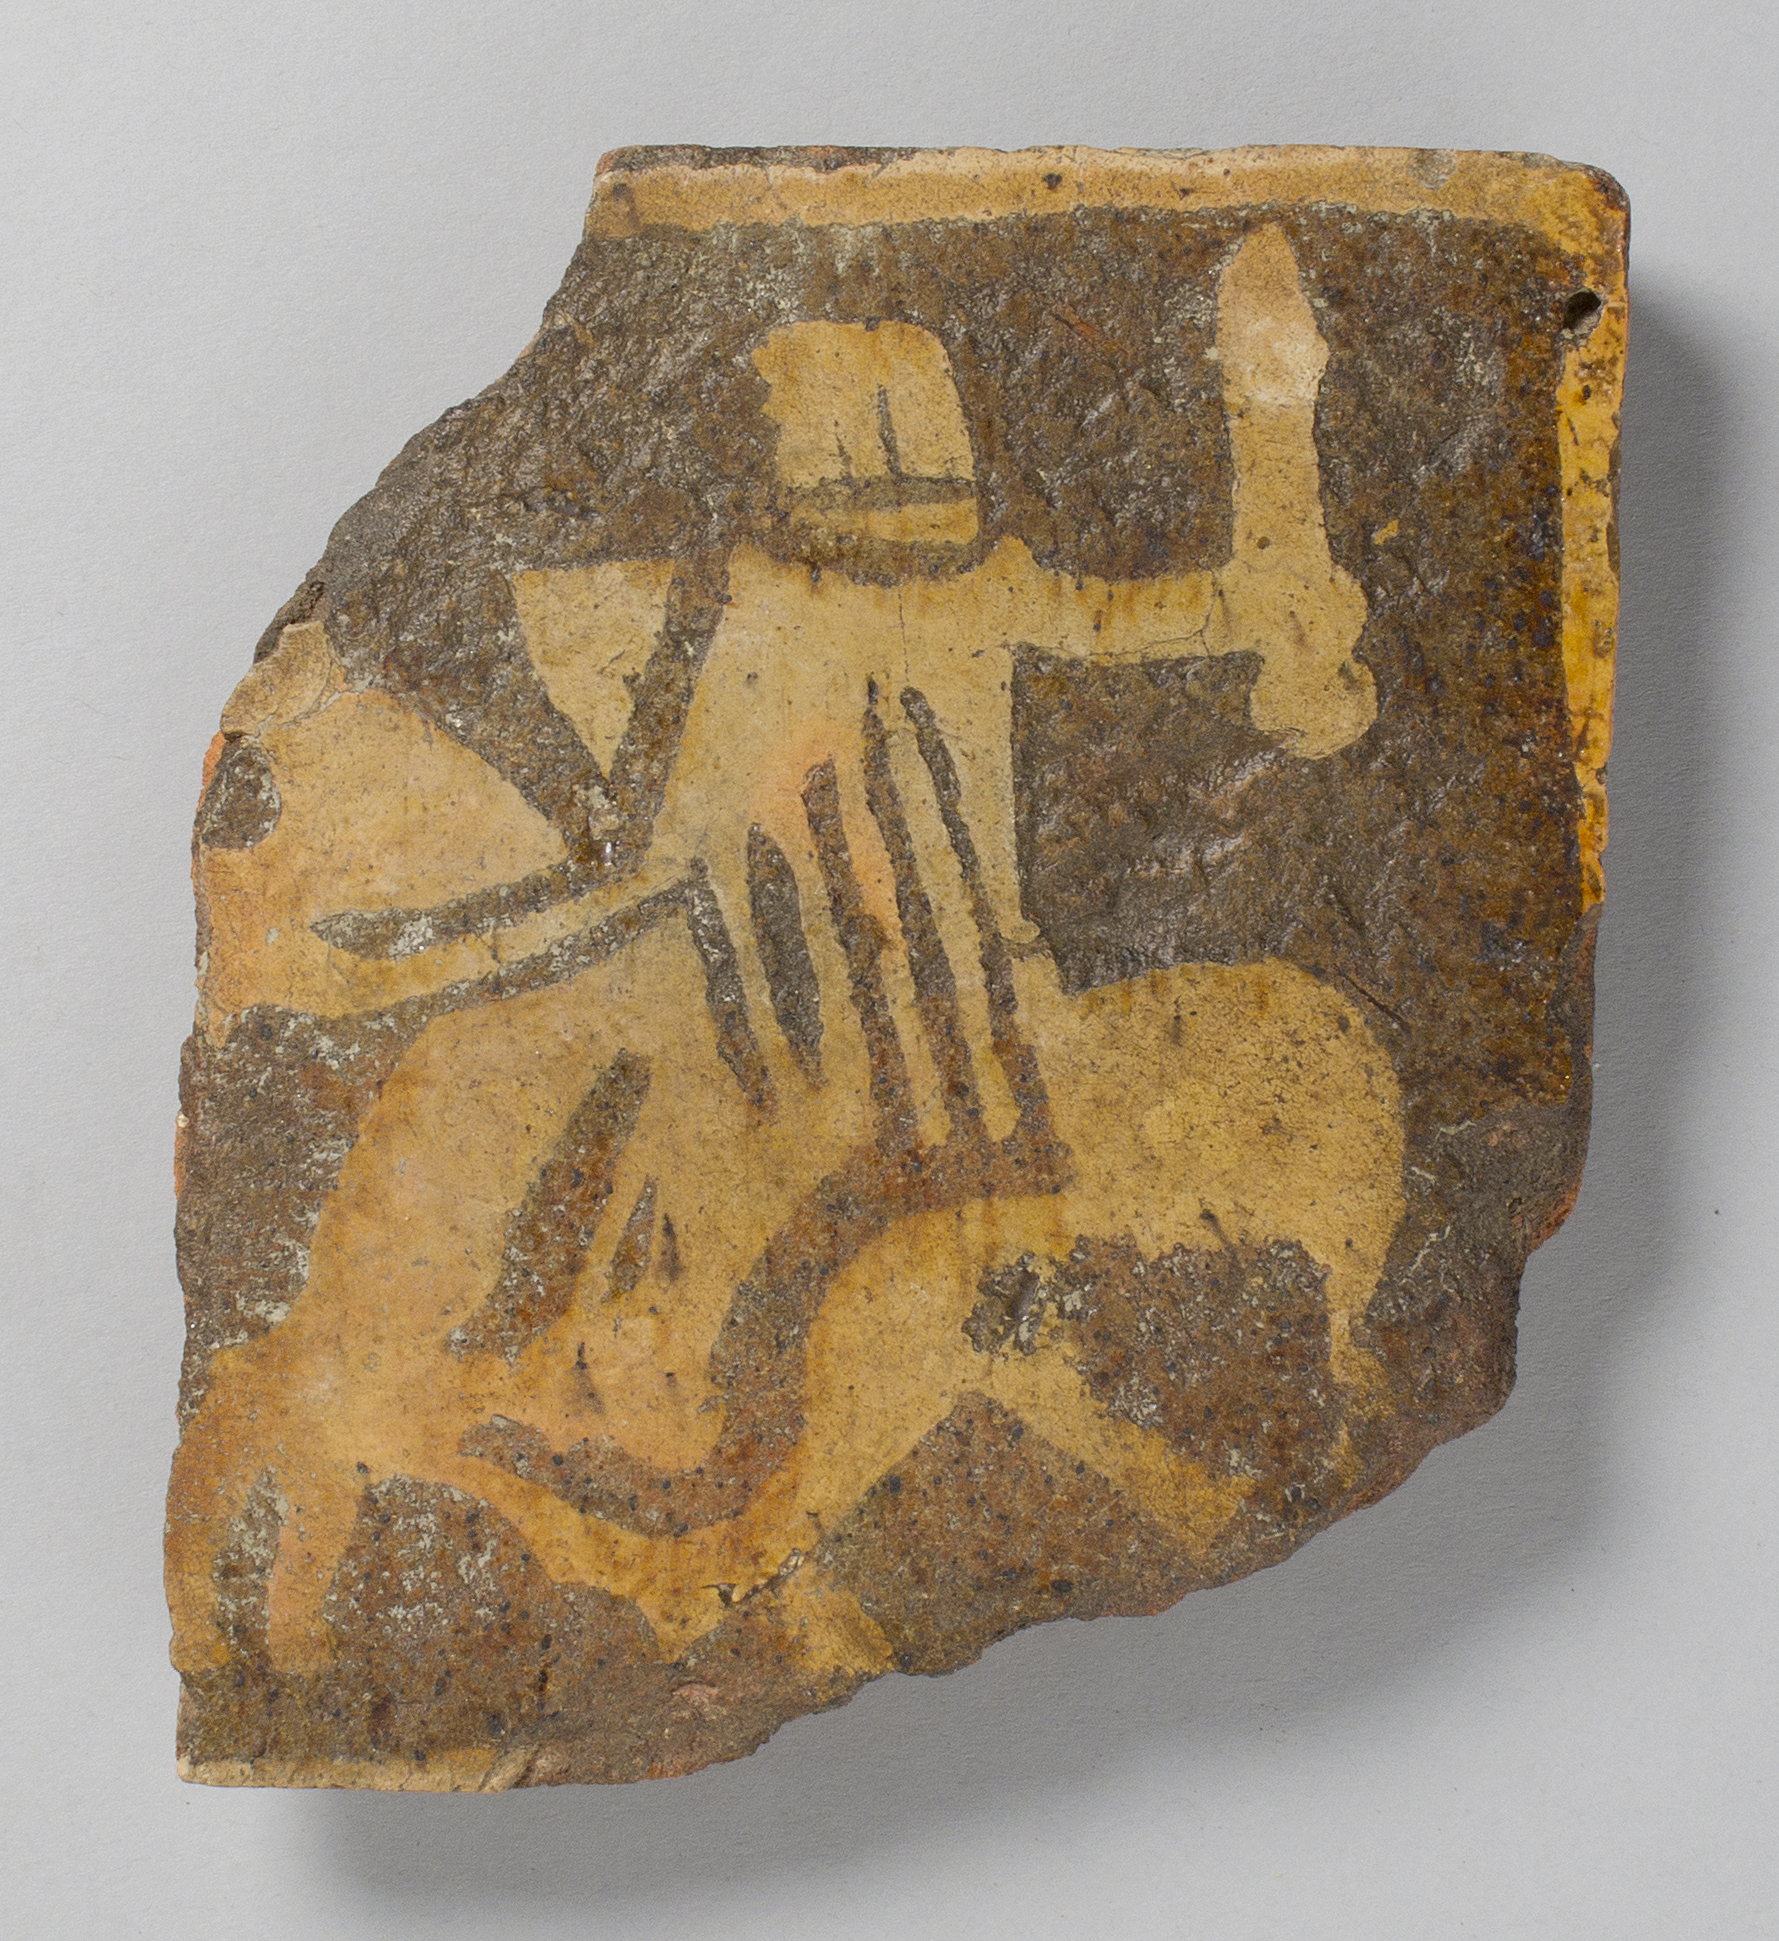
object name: tile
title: Tile, with helmeted knight on horseback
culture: british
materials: earthenware, glaze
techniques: firing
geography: england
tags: horses,knights